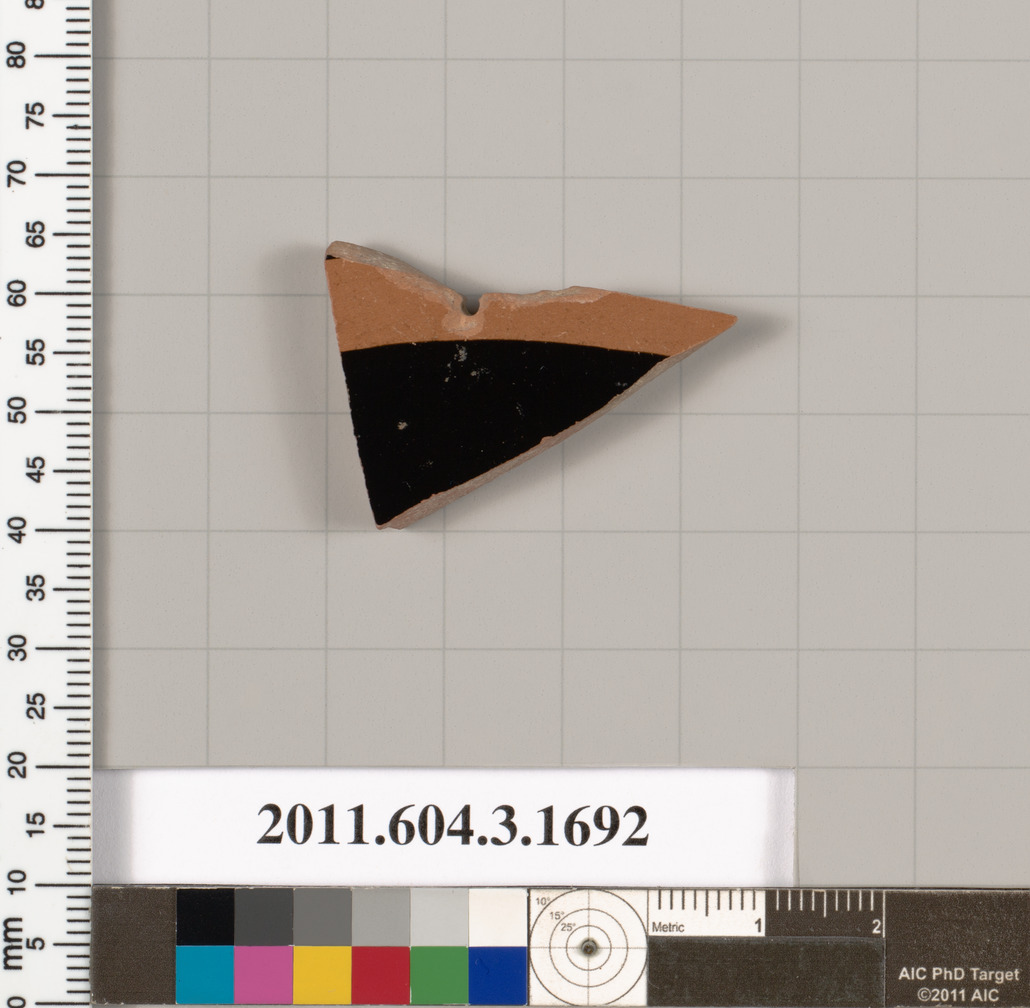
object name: kylix fragment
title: Terracotta fragment of a kylix: Band or lip cup (drinking cup)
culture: greek, attic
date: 550-526 BCE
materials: terracotta